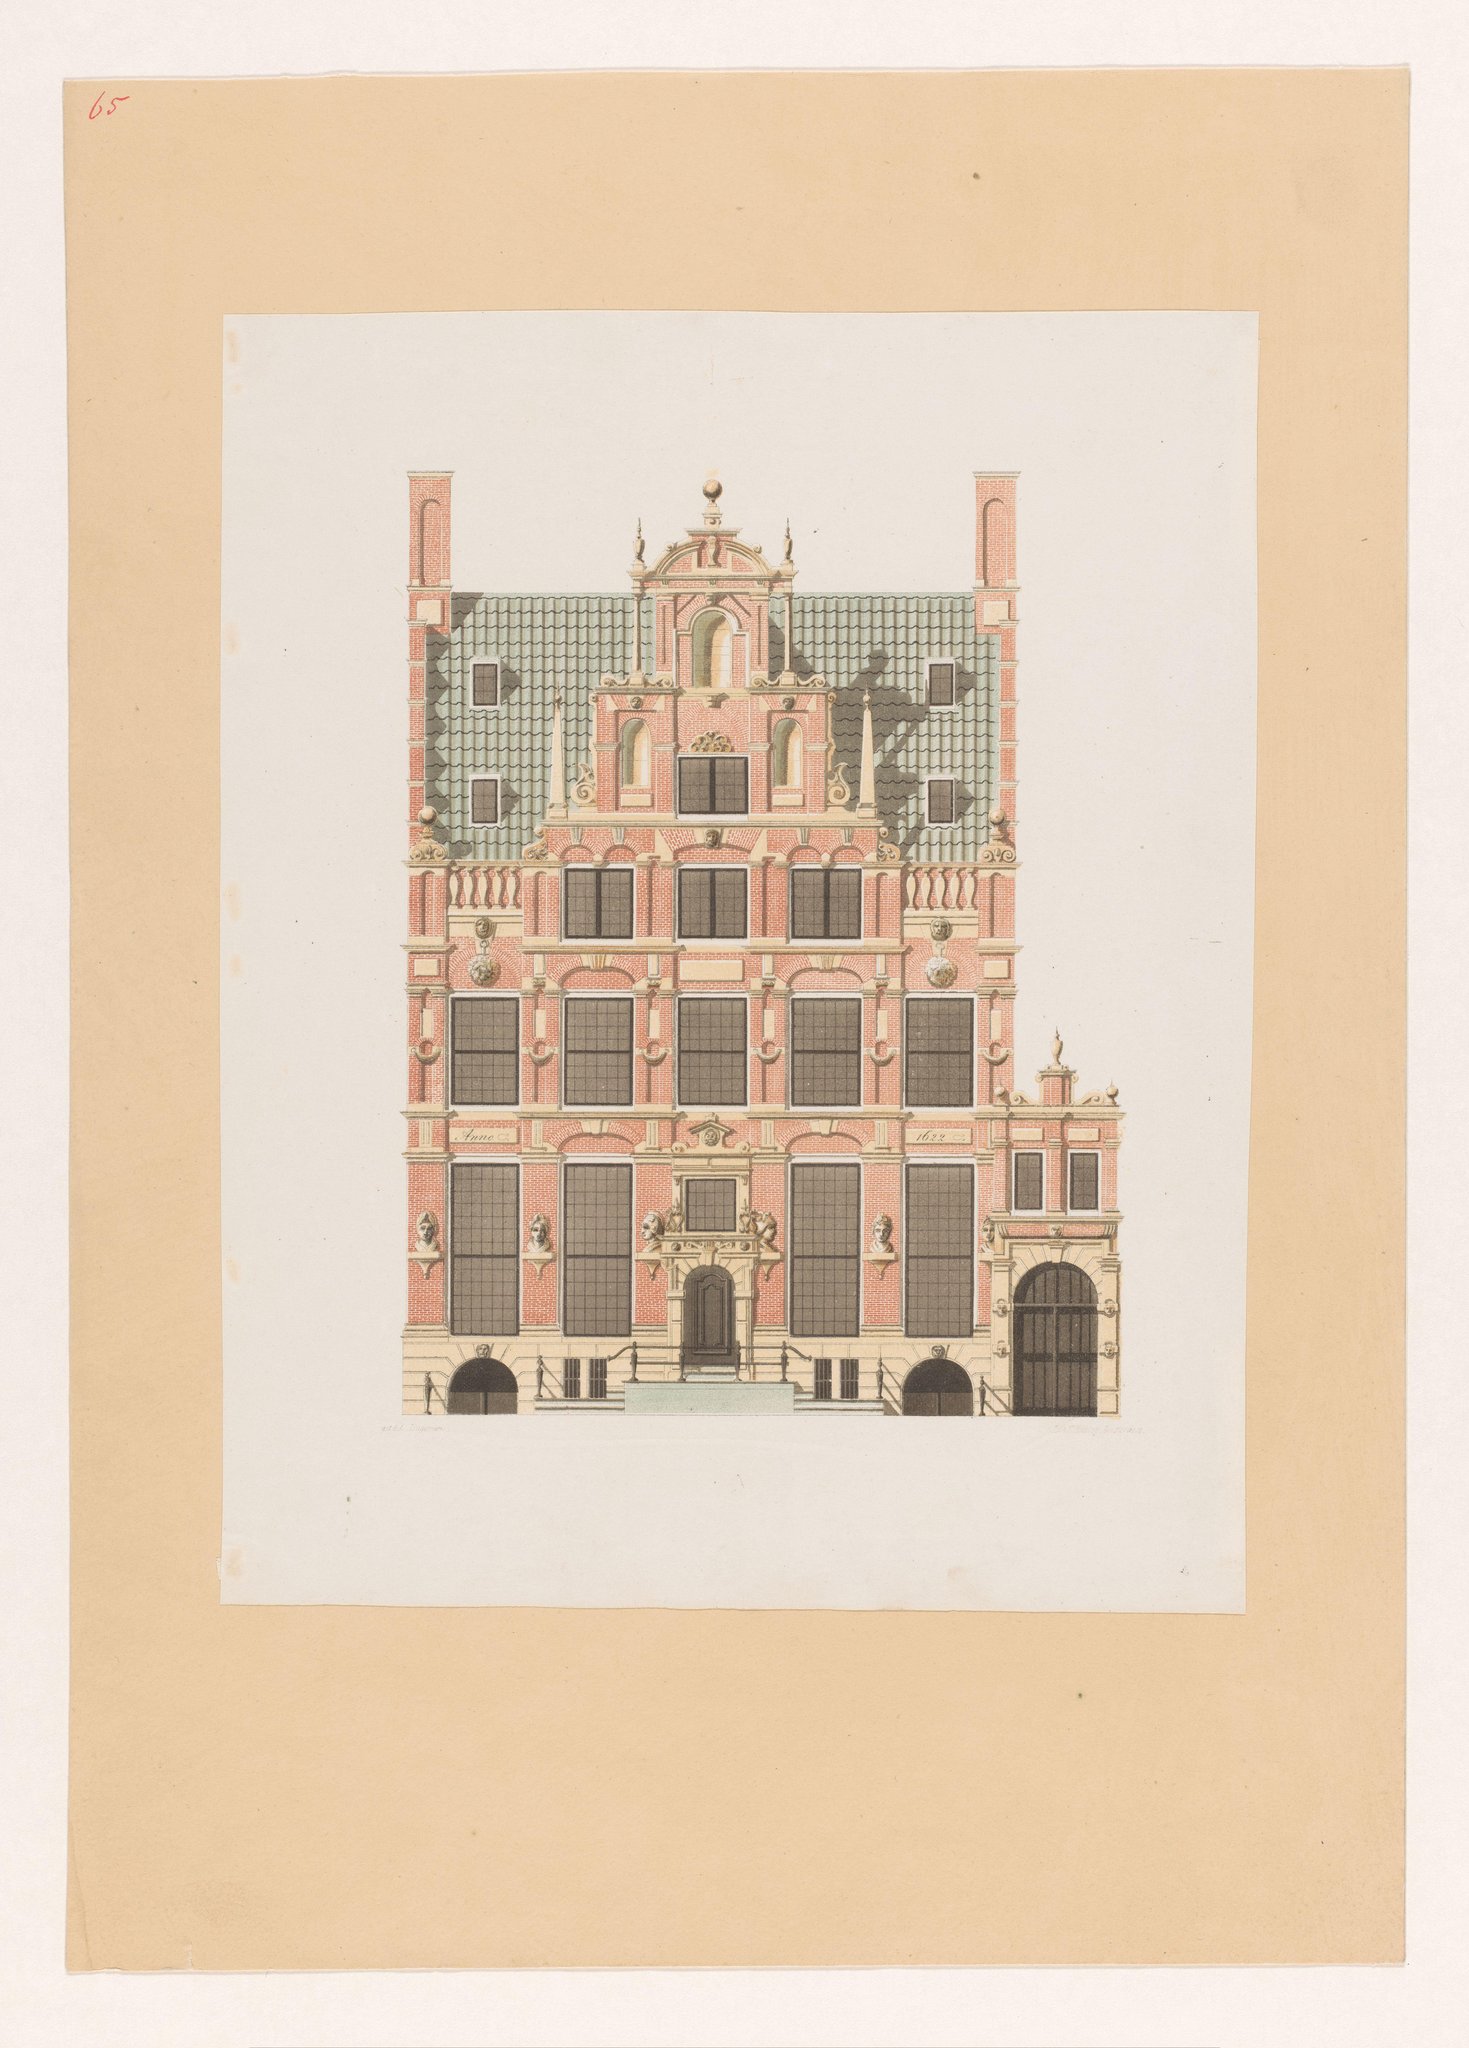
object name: print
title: Huis met de Hoofden in Amsterdam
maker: lambertus lingeman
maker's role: draughtsman, painter, print maker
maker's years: 1829-1894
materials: paper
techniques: lithograph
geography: amsterdam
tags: urban housing, decorated gable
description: Deze prent werd afgebeeld in: Bouwkundige Bijdragen. Amsterdam, I. van Bakkenes: 1851, plaat IX.